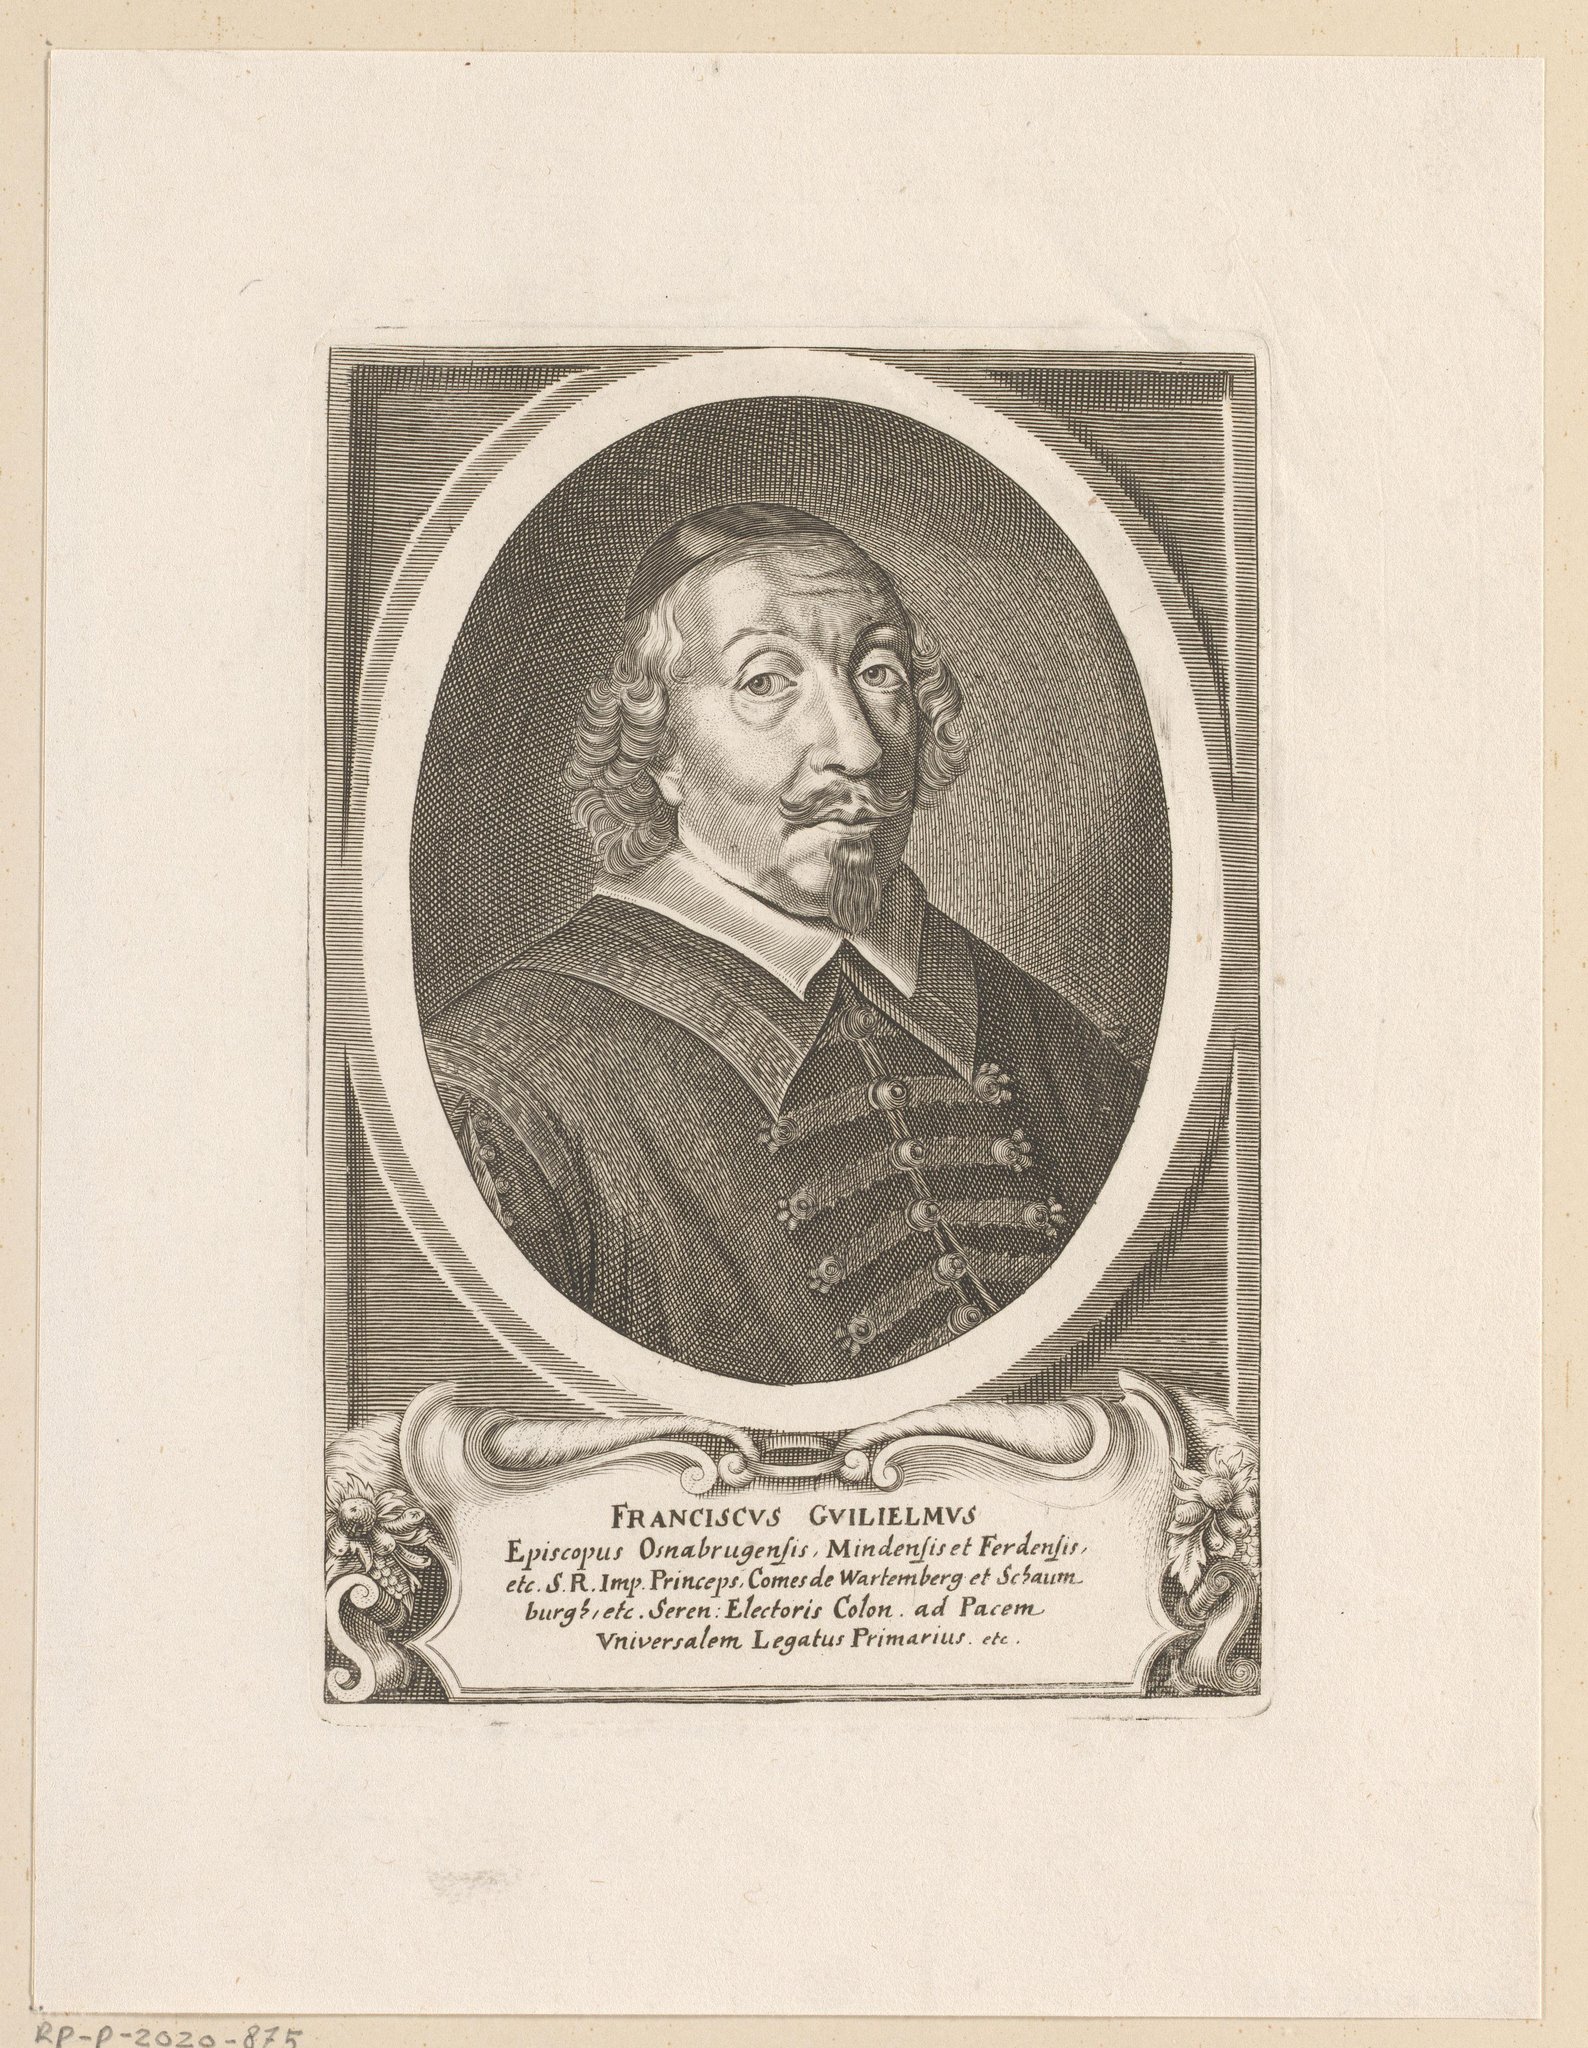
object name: print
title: Franciscus Guilielmus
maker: matthäus merian (i)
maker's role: print maker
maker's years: 1593-1650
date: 1652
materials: paper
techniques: engraving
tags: priest, archbishop, bishop, etc. (roman catholic), historical persons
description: Prent gebruikt in: Schleder, Johann Georg. Theatri Europaei Sechster und letzter Theil (...). Frankfurt am Main: Erven Mattheüs Merian, 1652.